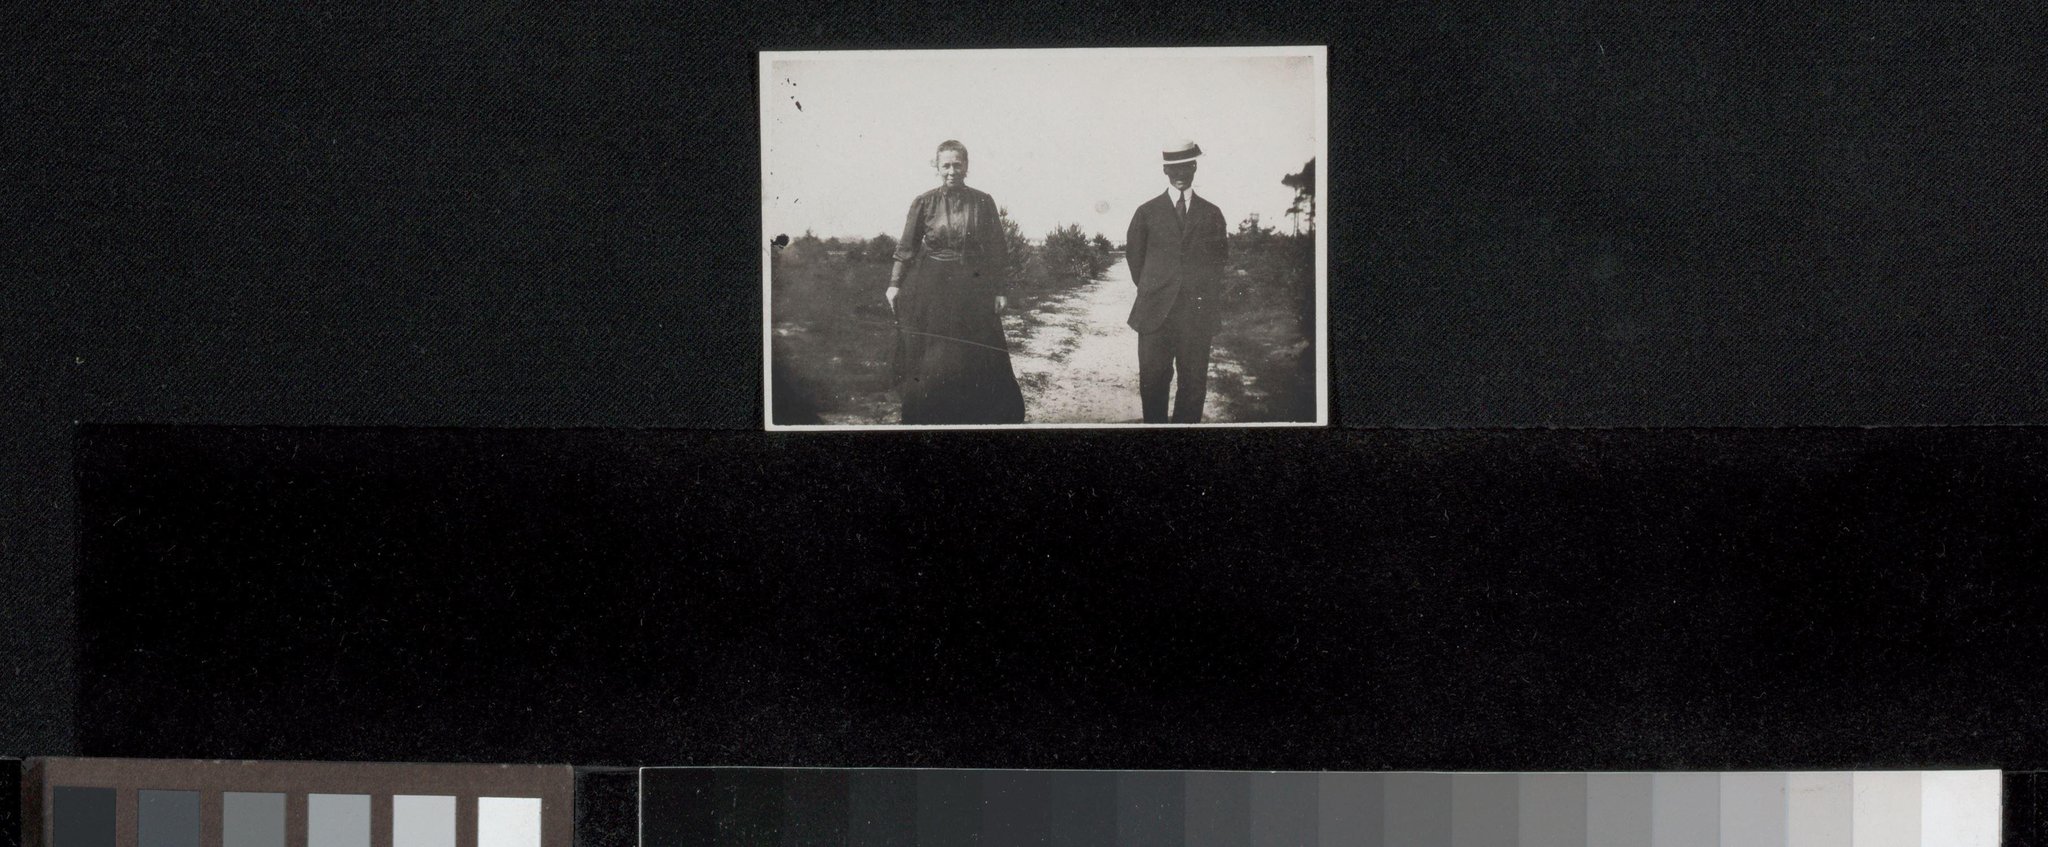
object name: photograph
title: Foto uit archief Jan Veth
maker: Anonymous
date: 1916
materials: photographic support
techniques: gelatin silver print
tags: louise catharina gorter-cnoop koopmans, dordrecht, painter, print maker, draughtsman, designer, jan veth, herman gorter, plain, historical persons (portraits and scenes from the life)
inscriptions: collector's mark: ‘RPK’